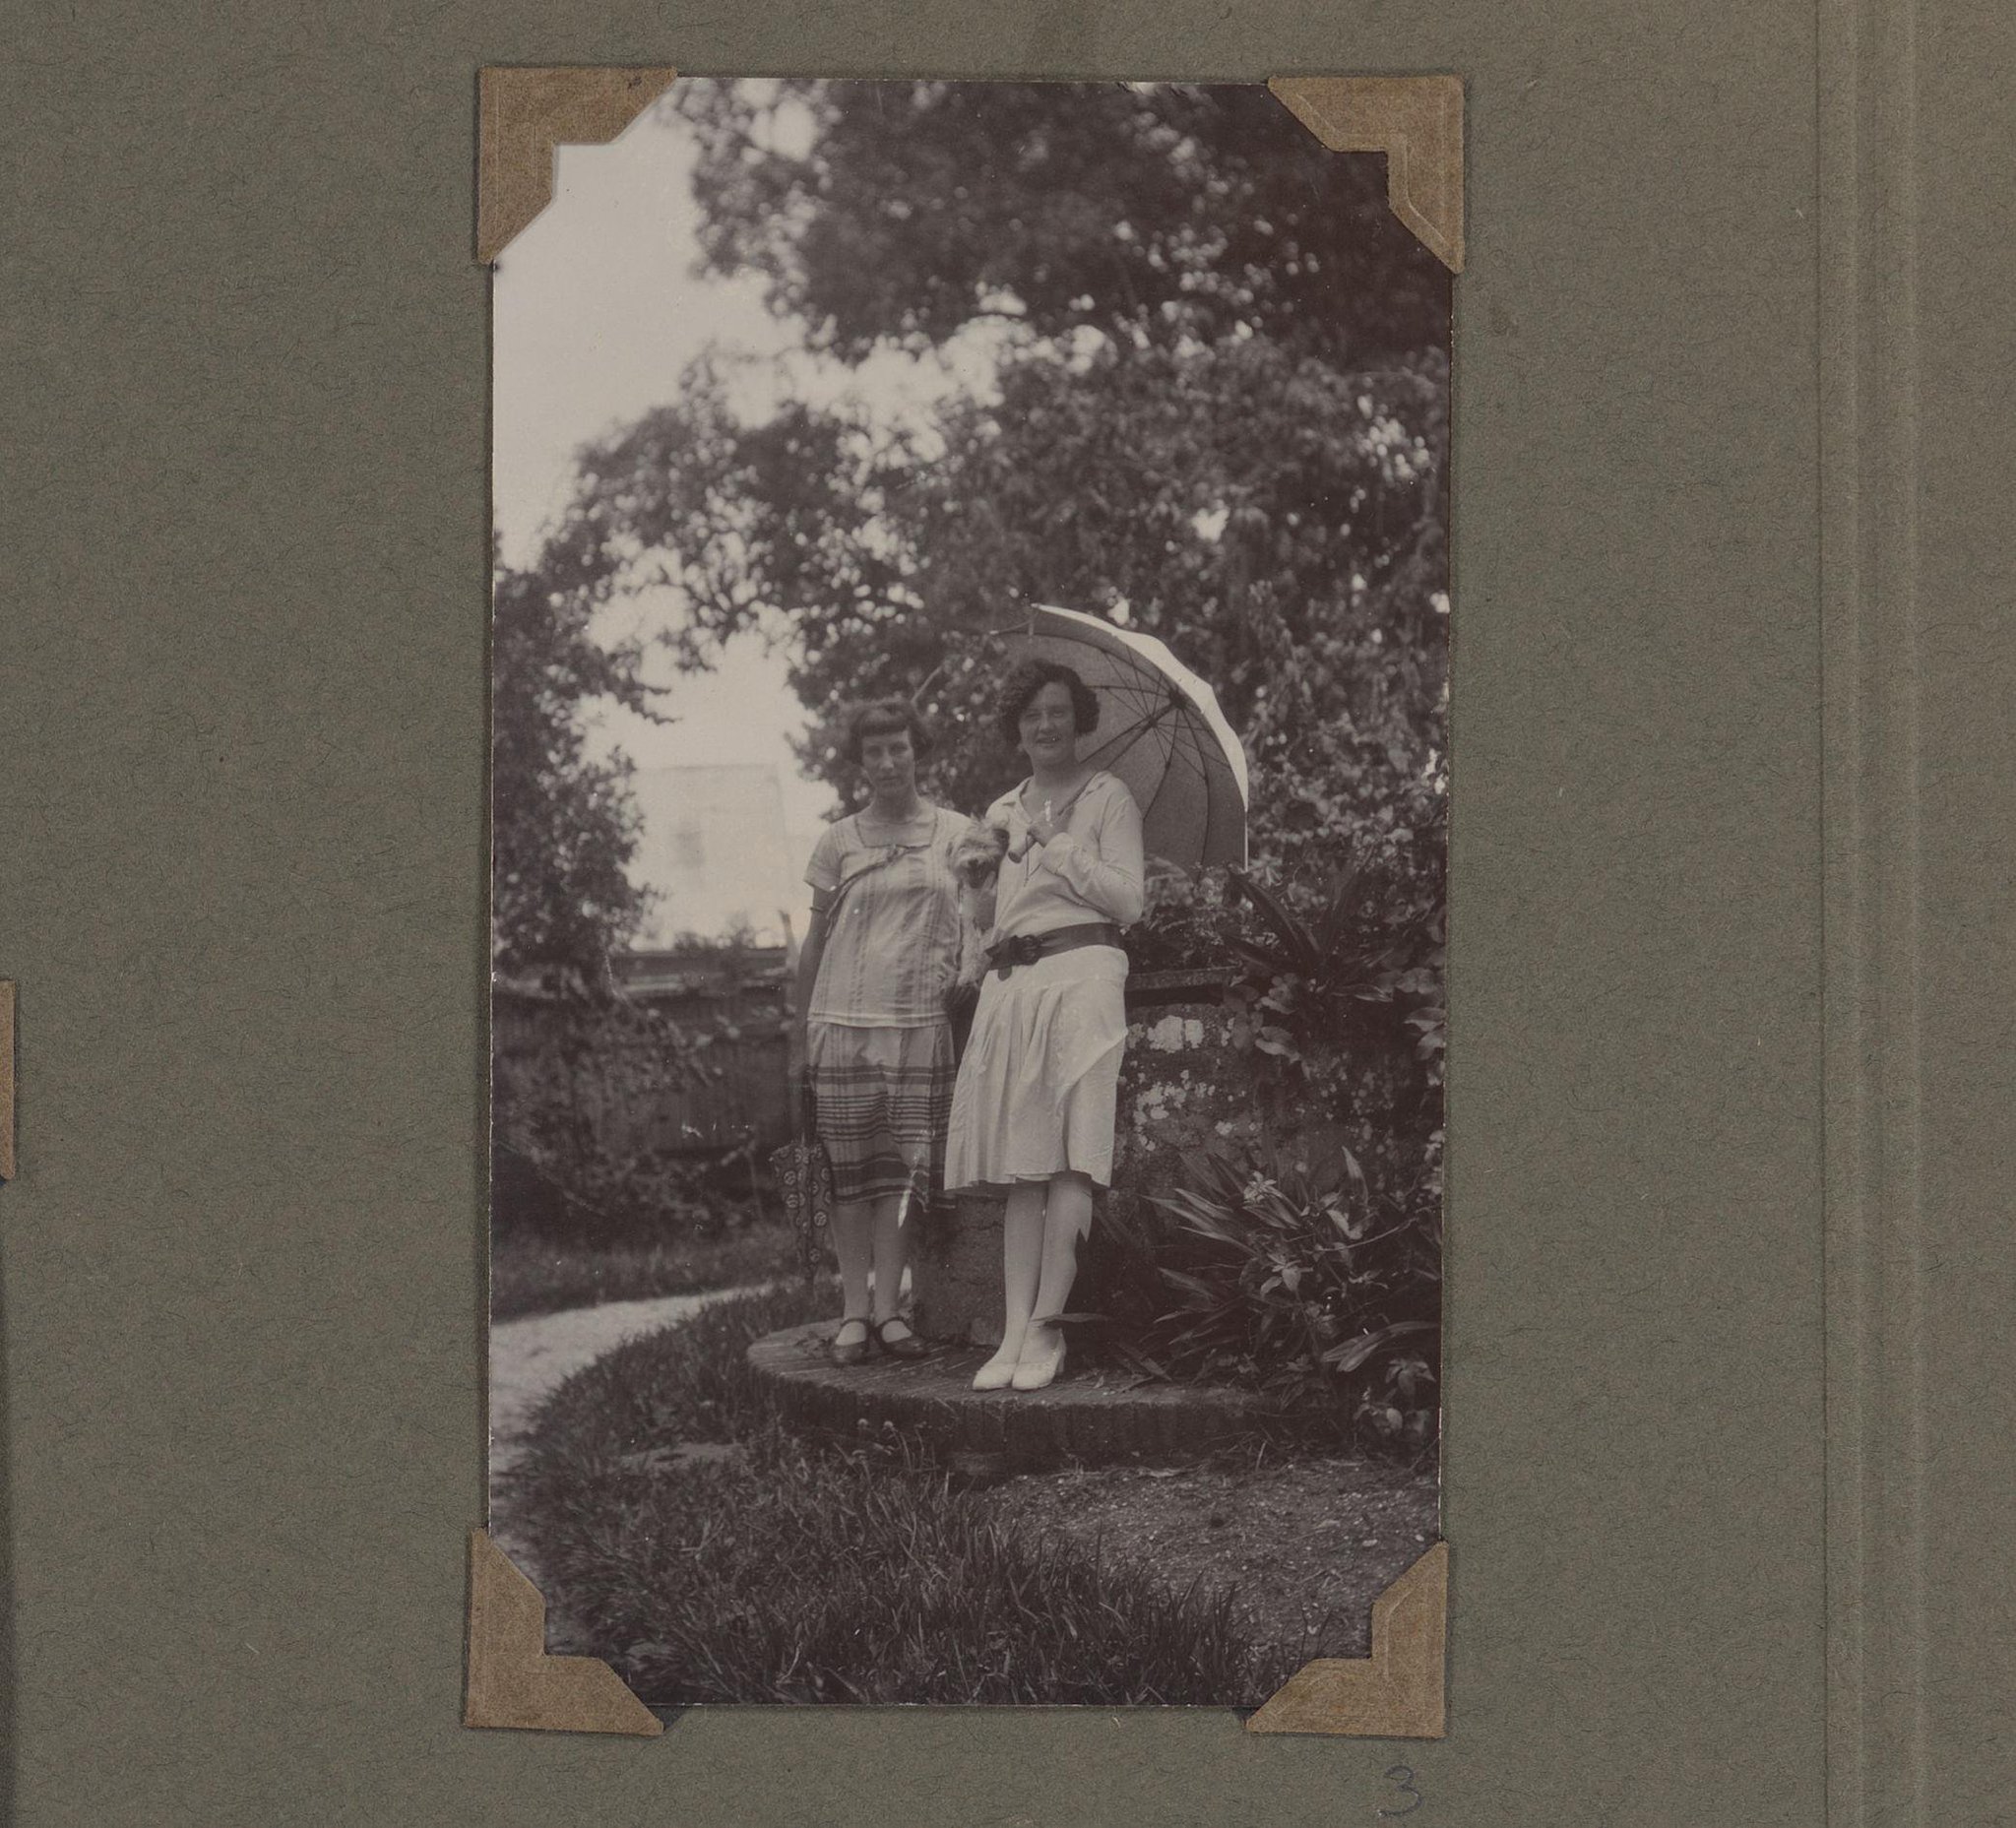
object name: photograph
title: Twee vrouwen van het gezin Jetten te Moengo, een van hen met parasol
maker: Anonymous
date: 1925-1927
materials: photographic support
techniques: photography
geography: suriname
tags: jetten, familie, moengo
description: Familiefoto van het gezin Jetten te Moengo. Foto op een bladzijde van een los albumblad. Onderdeel van het ensemble met foto's van de familie van ingenieur Jetten in de mijnbouwstad Moengo in Suriname.